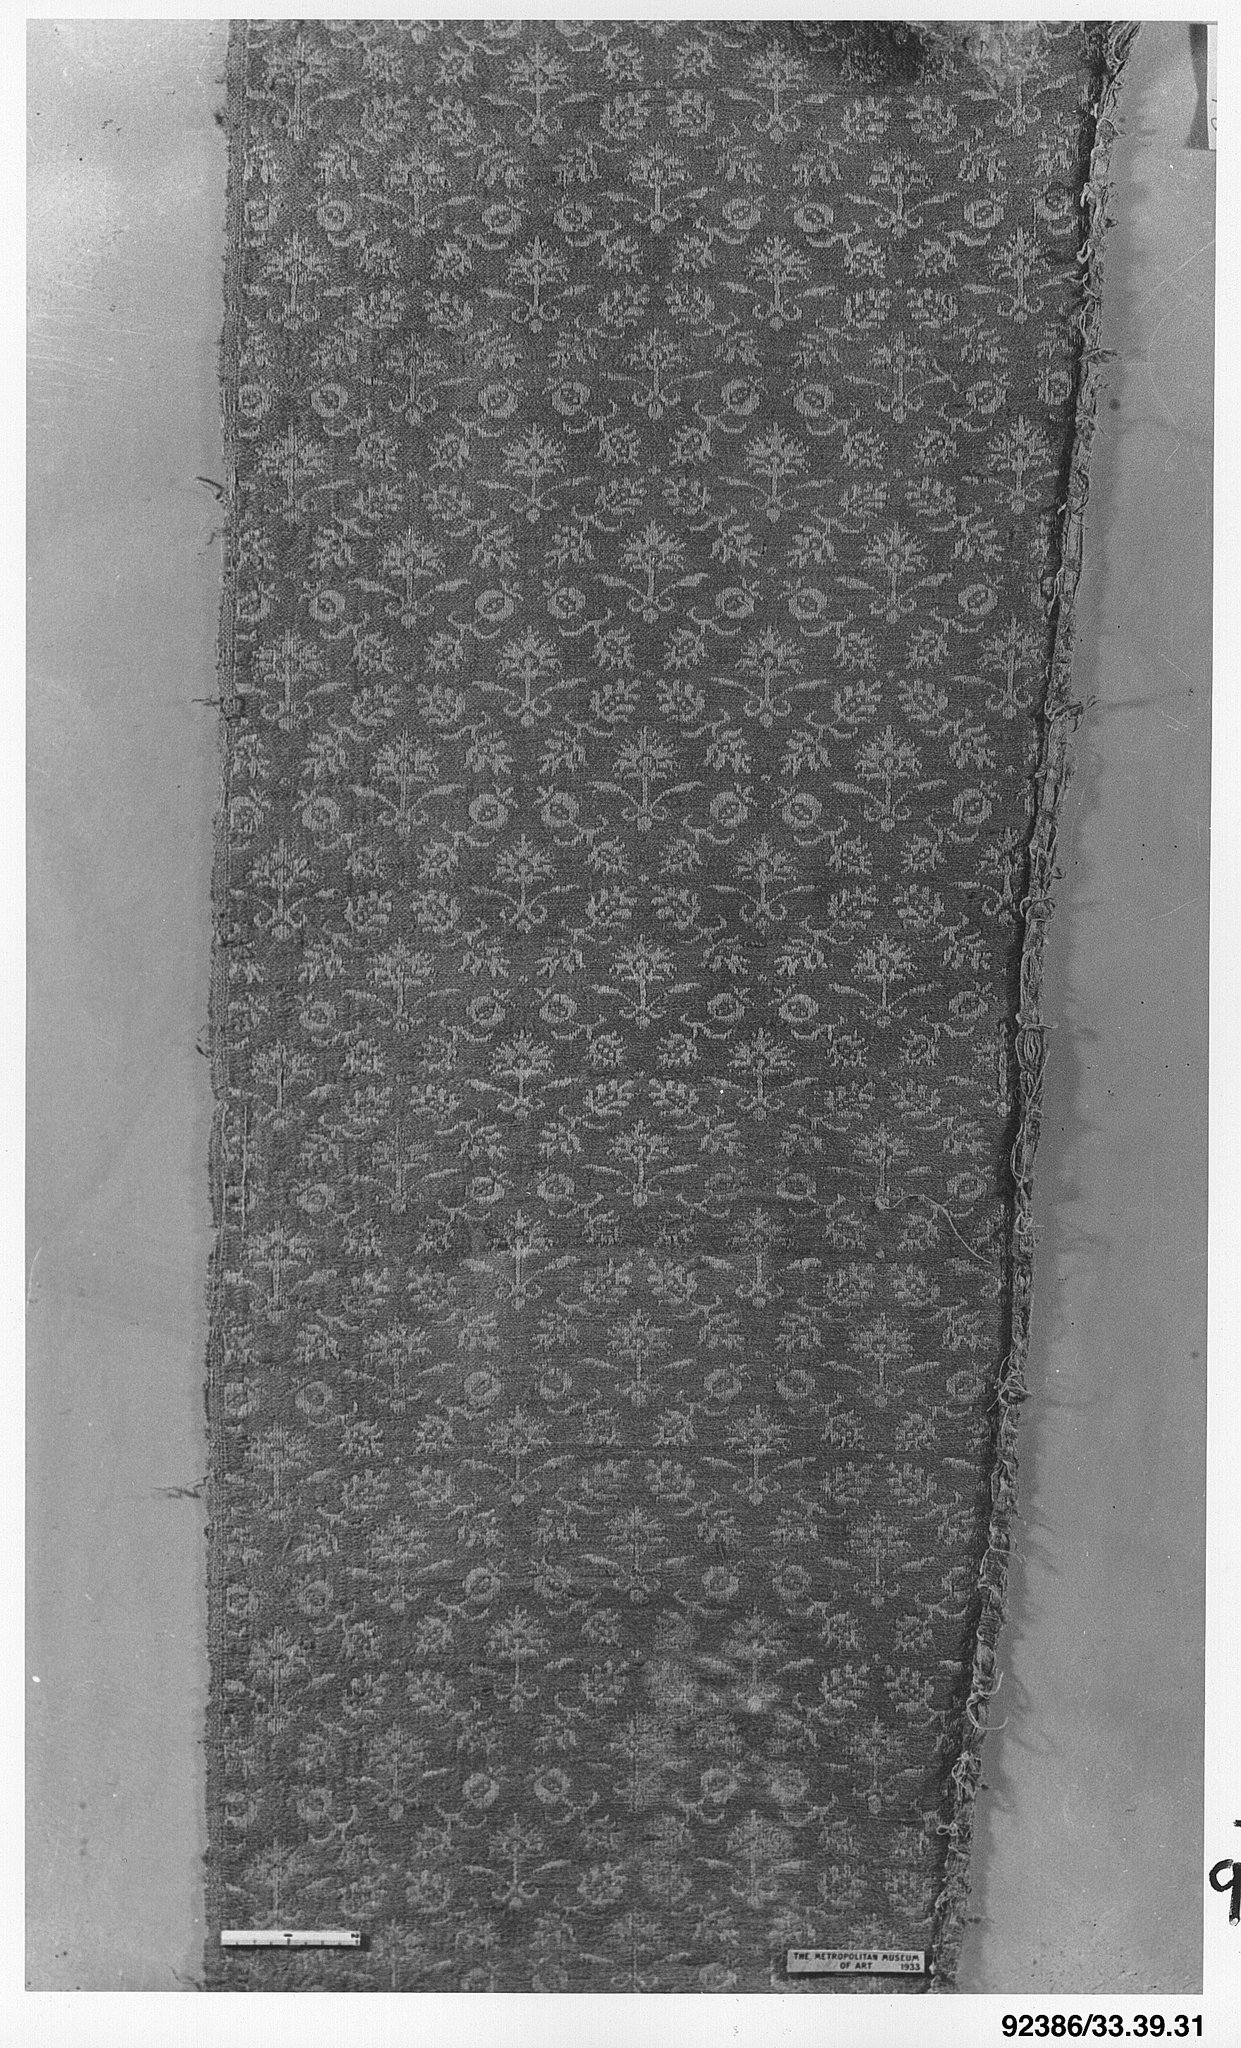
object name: fragment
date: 1501-1700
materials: cotton, wool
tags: flowers,leaves